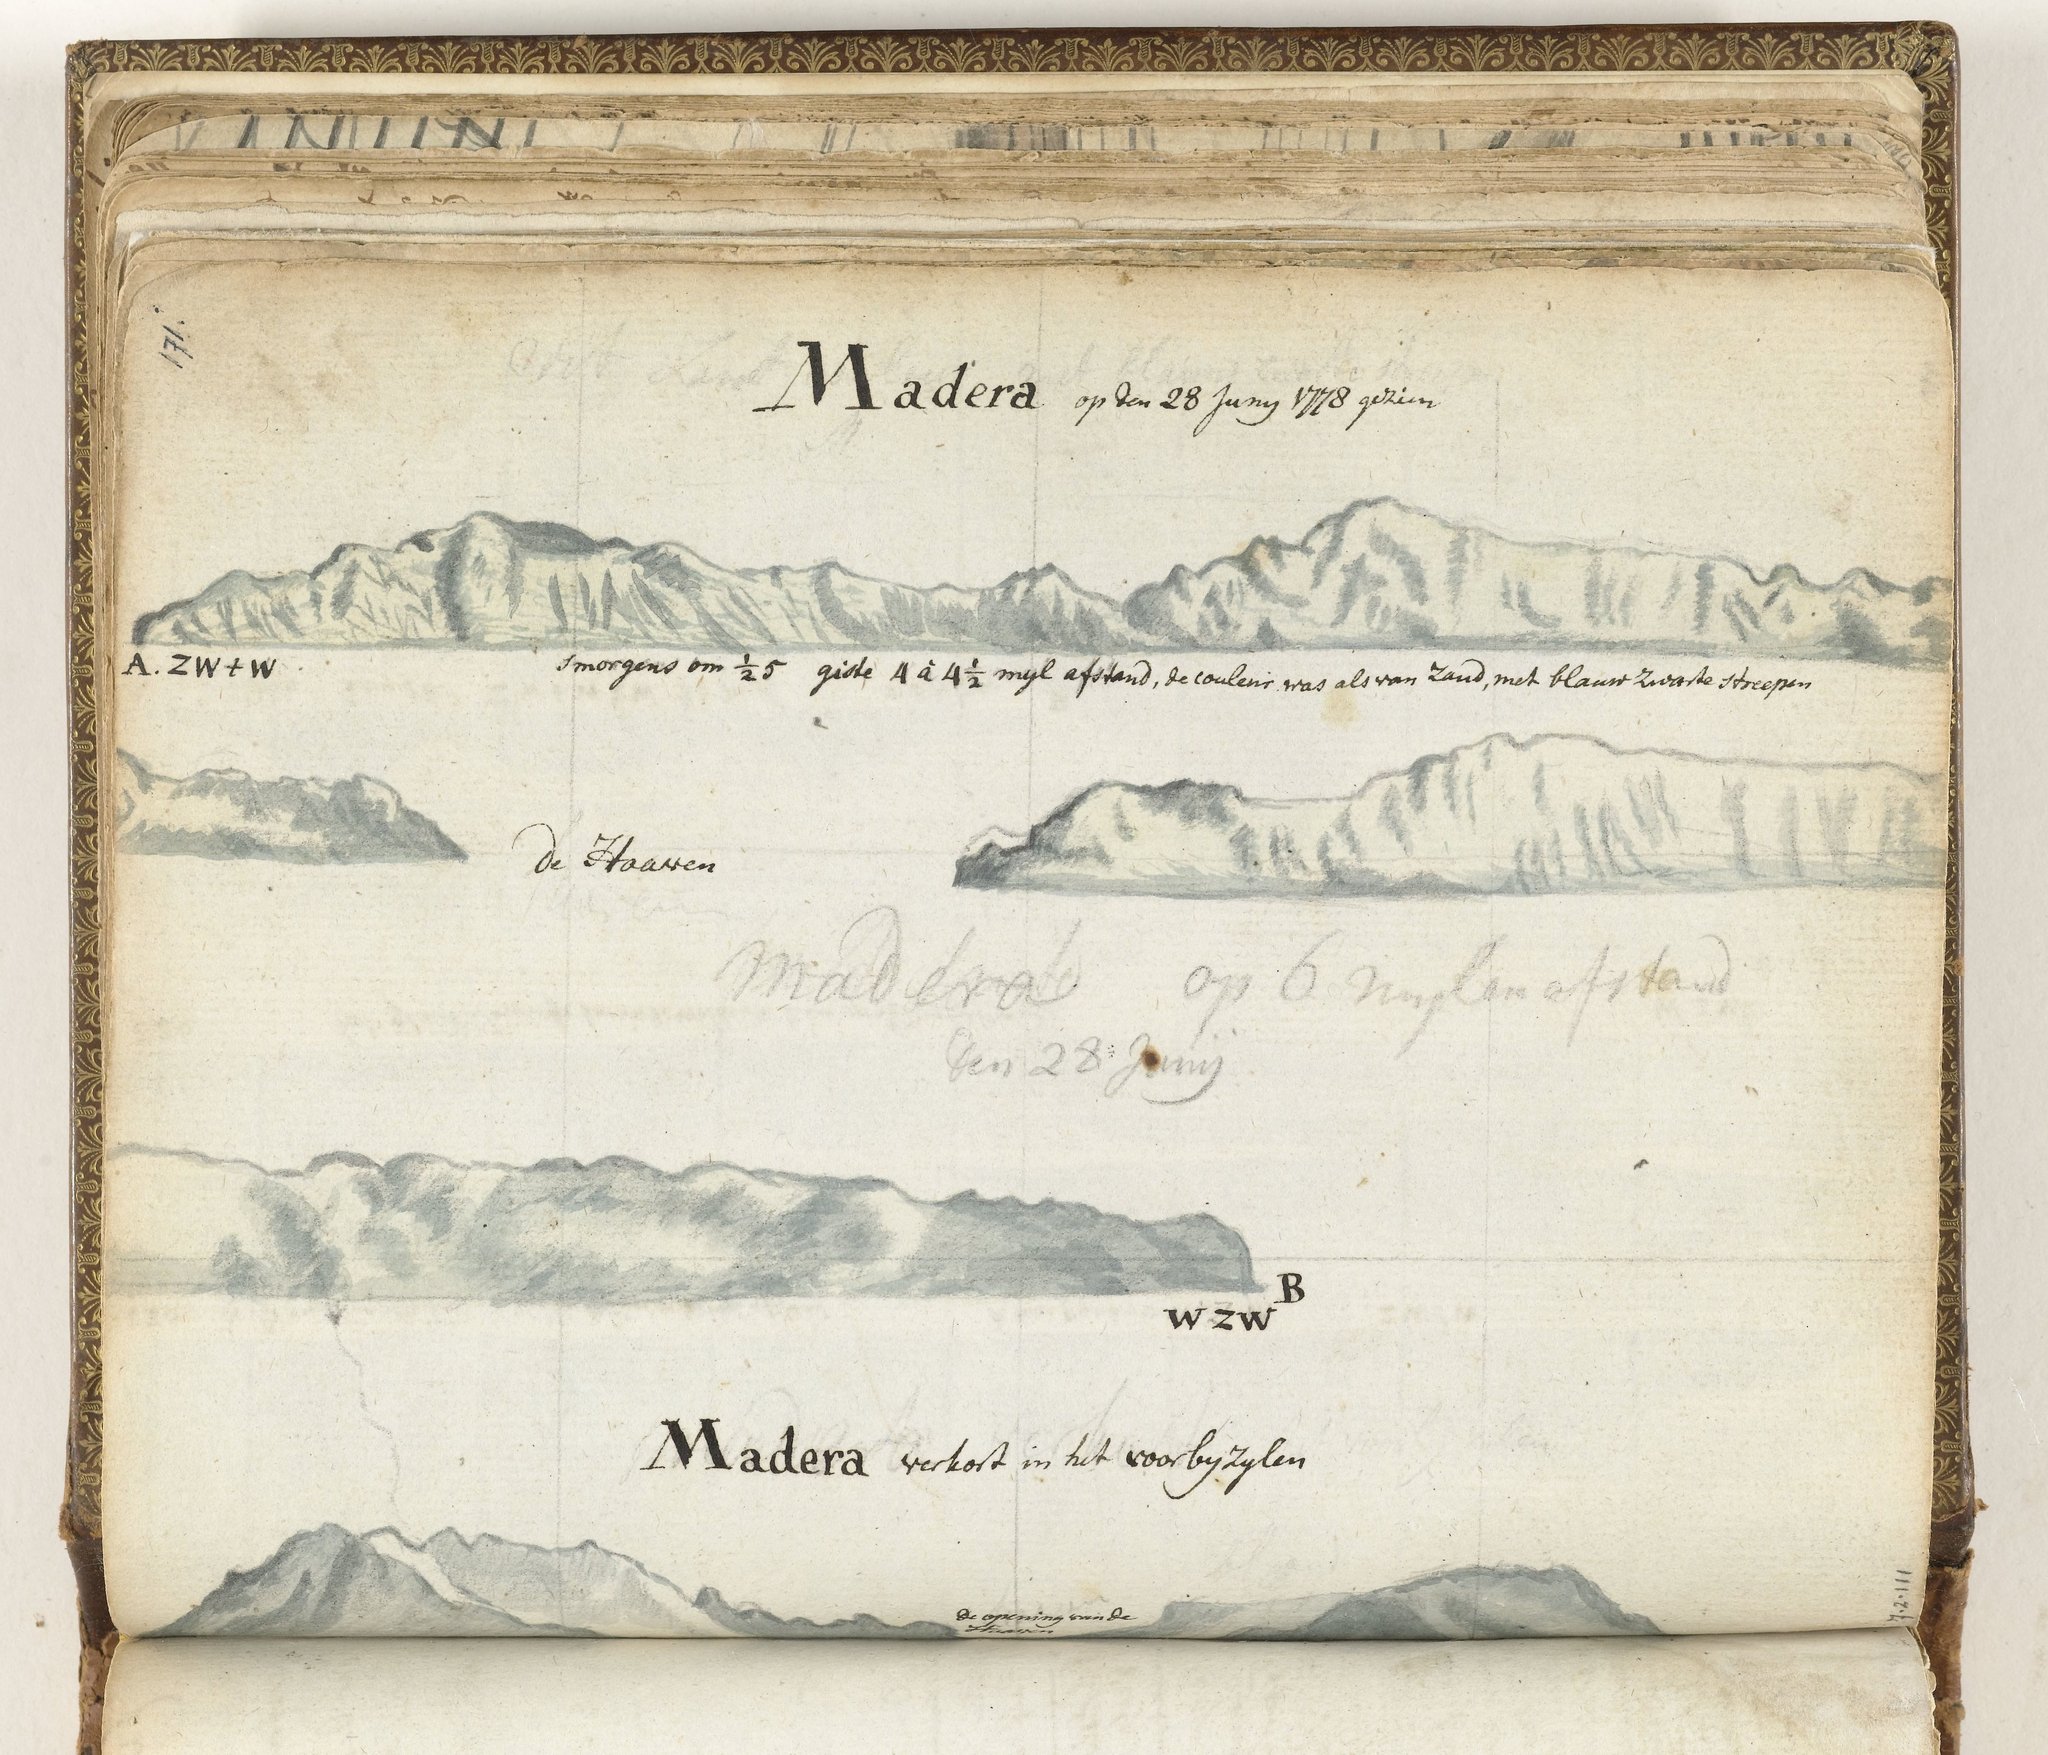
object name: drawing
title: Kustprofiel van Madeira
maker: jan brandes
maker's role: draughtsman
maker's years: 1743-1808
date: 1778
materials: paper, pencil, watercolor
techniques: brush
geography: madeira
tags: island, coast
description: Kleurtekening van de kust van Madeira, getekend tijdens het voorbijzeilen op 6 mijl (denkelijk Duitse) afstand. In stukken onder elkaar. Met opschrift. Onderdeel uit het schetsboek van Jan Brandes, dl. 2 (1808), p. 171.